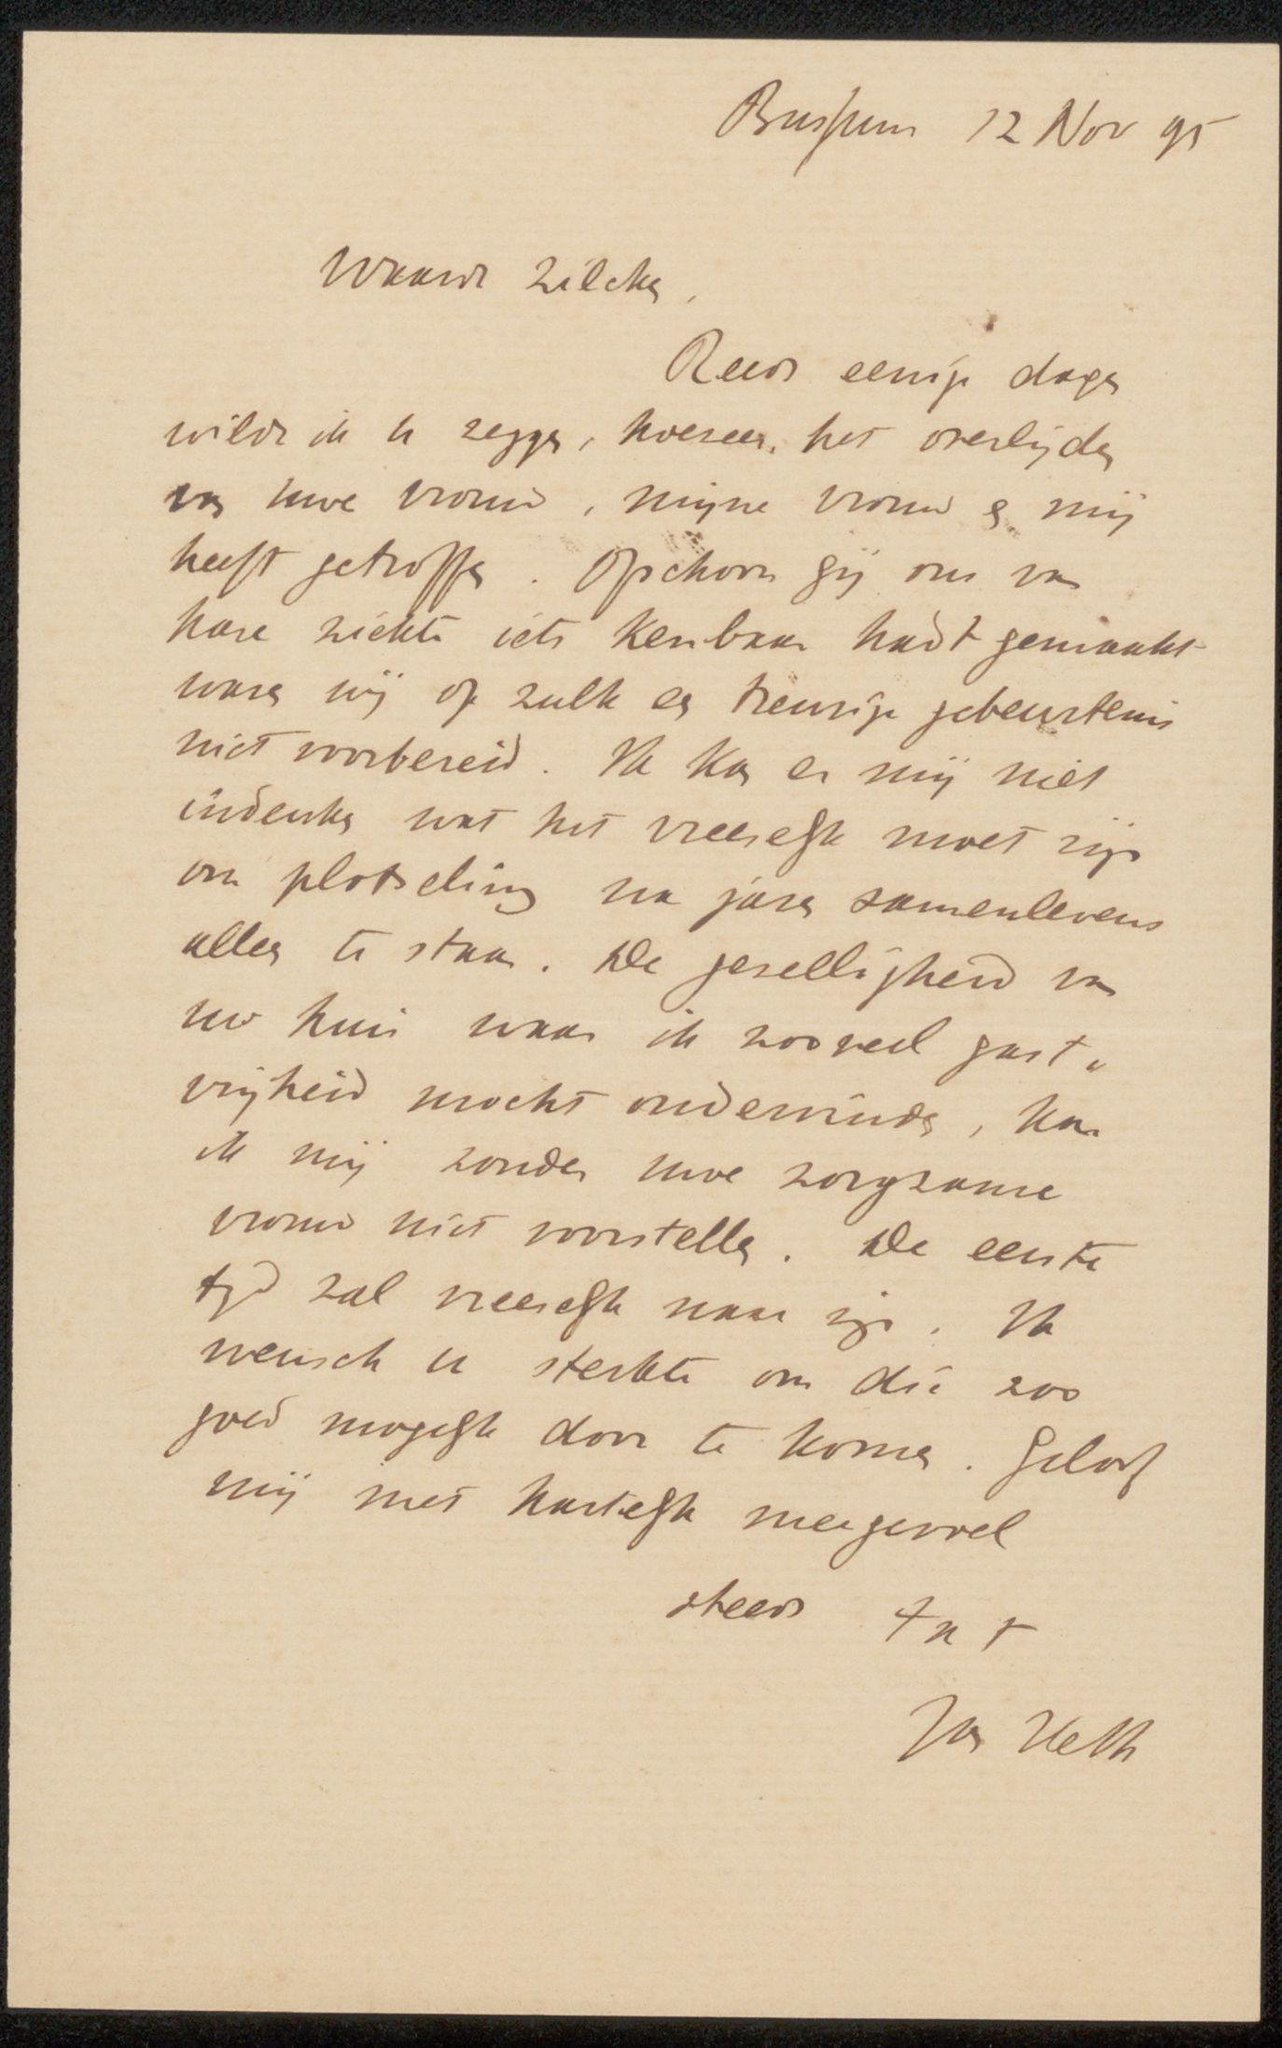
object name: letter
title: Brief aan Philip Zilcken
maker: jan veth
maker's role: designer, draughtsman, painter, print maker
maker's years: 1864-1925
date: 1895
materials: ink, paper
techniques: pen, writing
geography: bussum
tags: helène lambertine hauzeur, philip zilcken, passions, emotions, affections, diseases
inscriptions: watermark